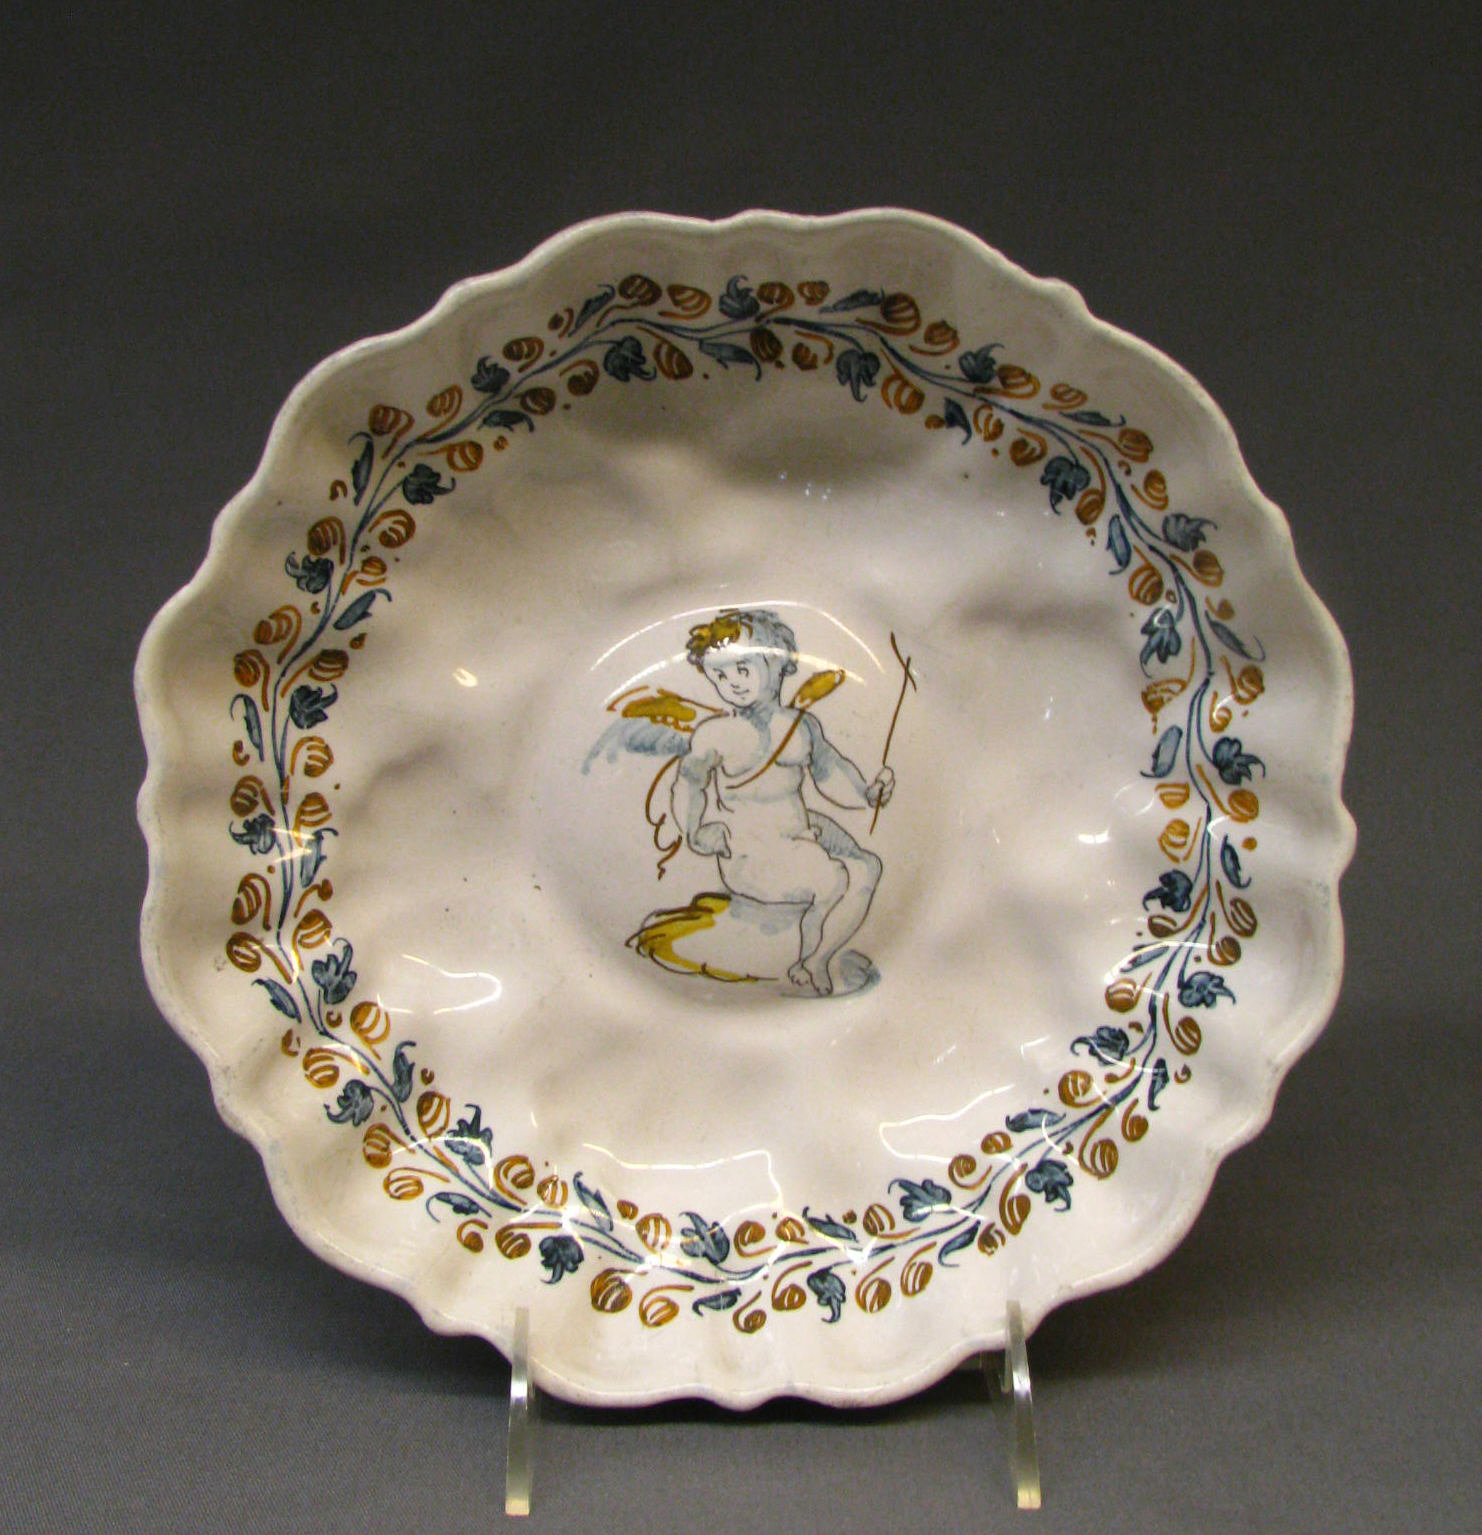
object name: footed dish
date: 1601-1650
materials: earthenware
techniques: glazing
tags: putti